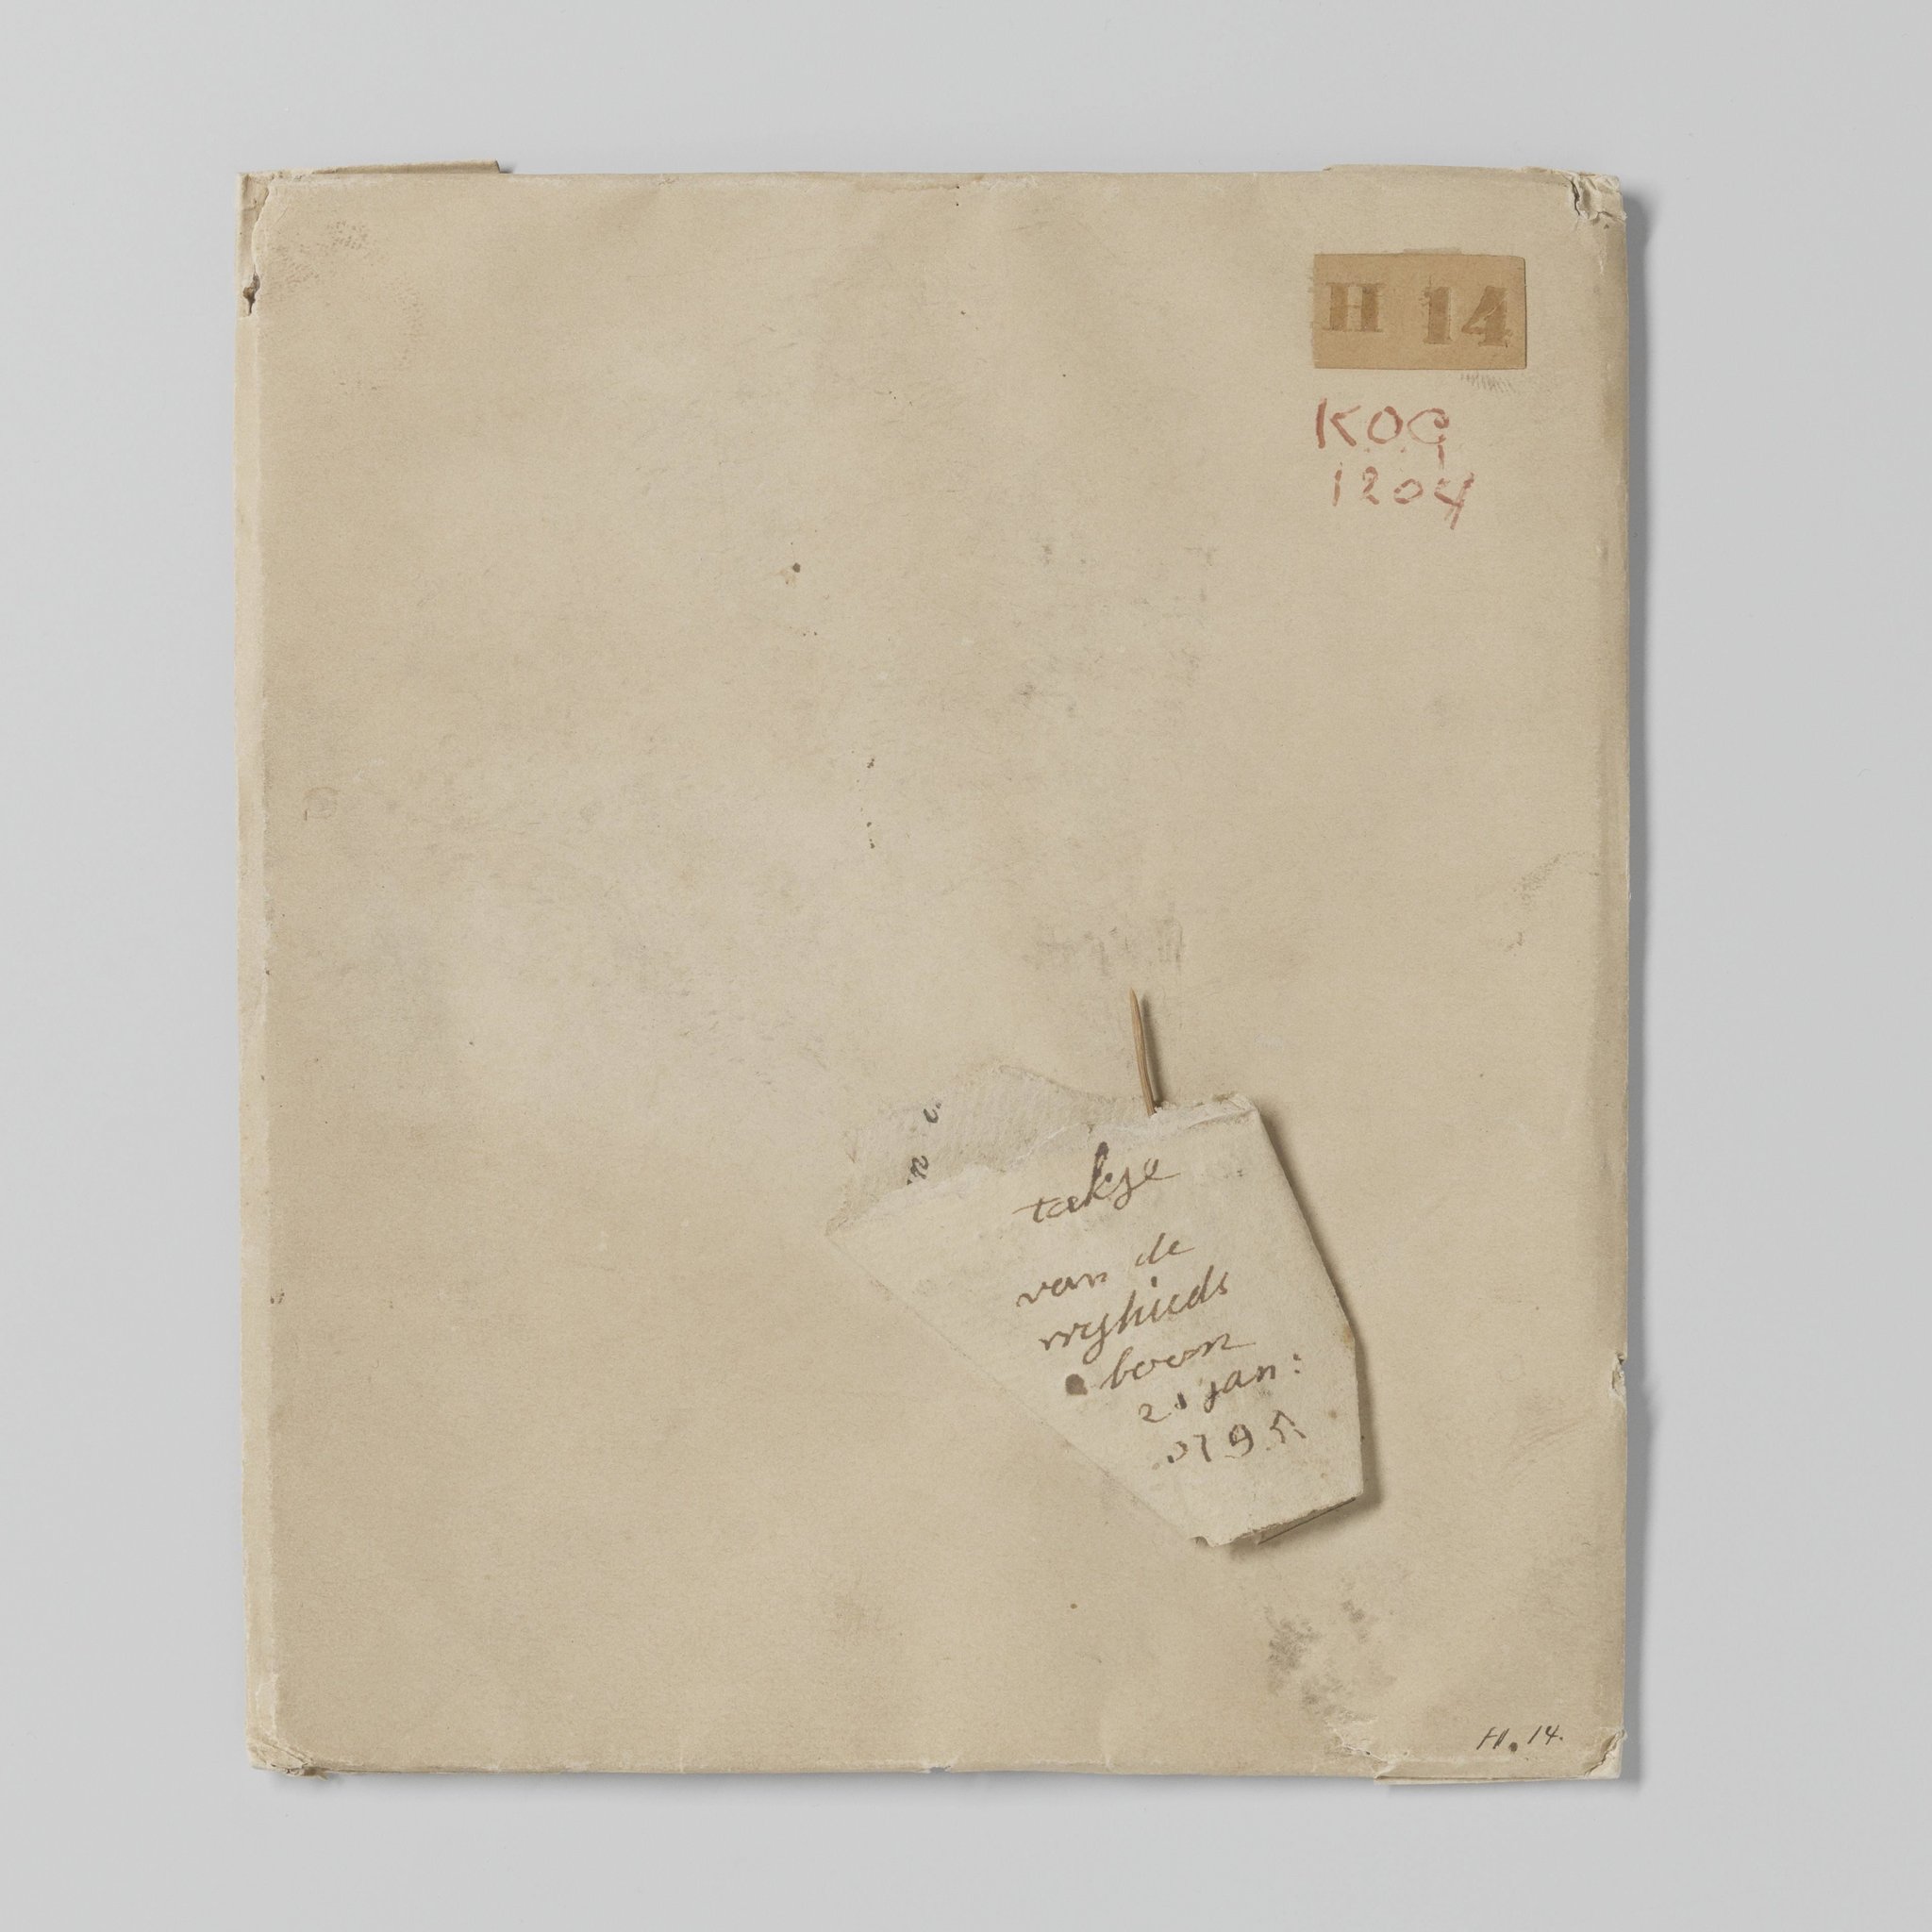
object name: letter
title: Twig from a liberty tree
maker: Anonymous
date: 1795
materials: paper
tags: amsterdam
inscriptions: inscription: ‘takje / van de / vrijheids / boom’, inscription: ‘ATLAS van AMSTERDAM / van D.C. MEIJER Jr. / Amst. / afd / 208’, date: ‘21 jan: 1795’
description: Brief behorend bij takje van een vrijheidsboom. Takje van een spar op een papier waaraan een etiket met opschrift 'takje van de vrijheidsboom 21 januari 1795'. Op achterzijde 'ATLAS VAN AMSTERDAM/ van D.C. Meijer jr' en 'Amst/ afd/ 208'. Afkomstig van de vrijheidsboom die bij de komst van de Franse troepen in Amsterdam werd opgericht op de Dam.